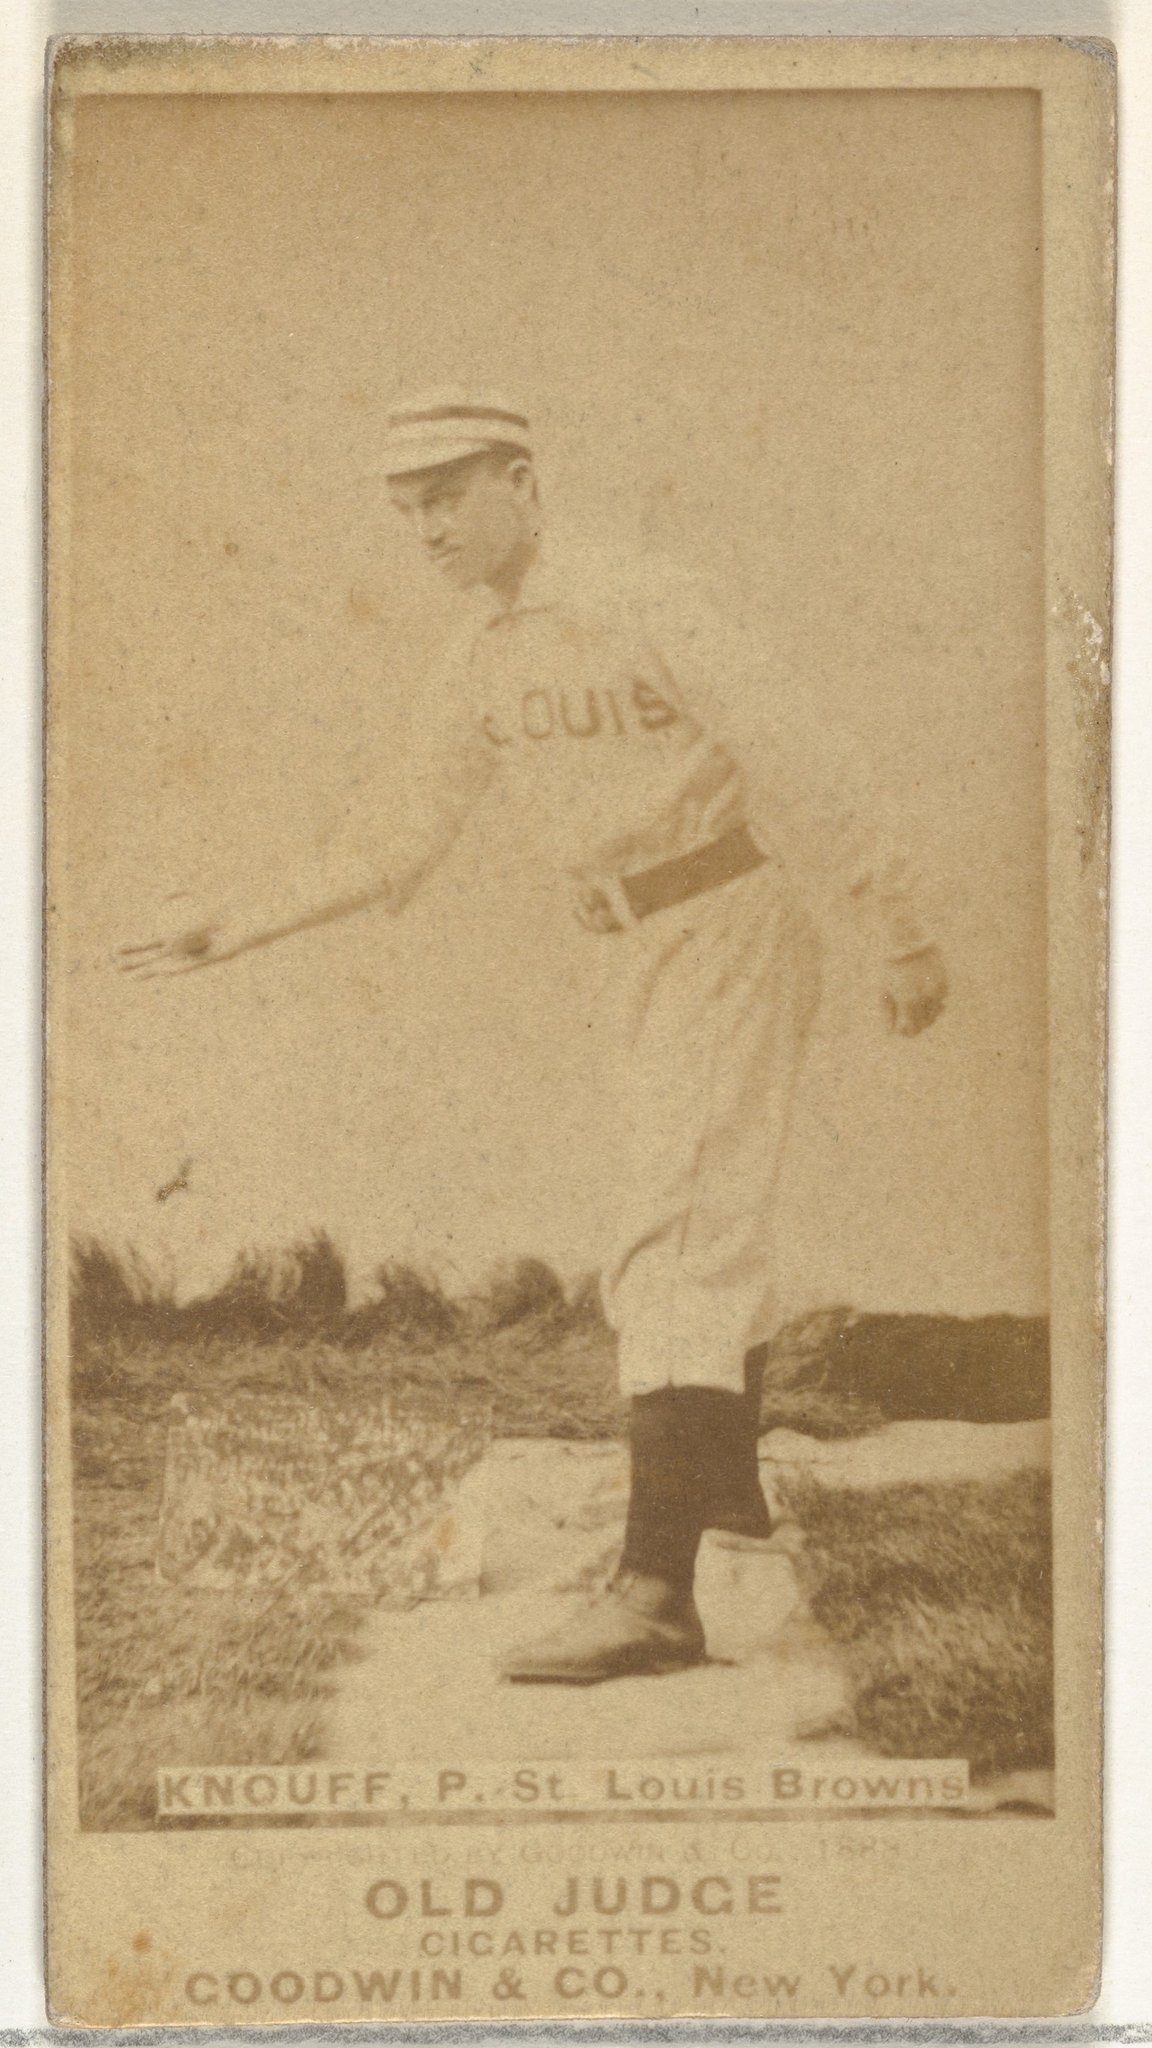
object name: baseball card, photograph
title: Edward Augustine "Ed" Knouff, Pitcher, St. Louis Browns, from the Old Judge series (N172) for Old Judge Cigarettes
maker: goodwin & company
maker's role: publisher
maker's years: 1850-1950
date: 1887-1890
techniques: albumen silver print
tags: men,portraits,baseball,athletes